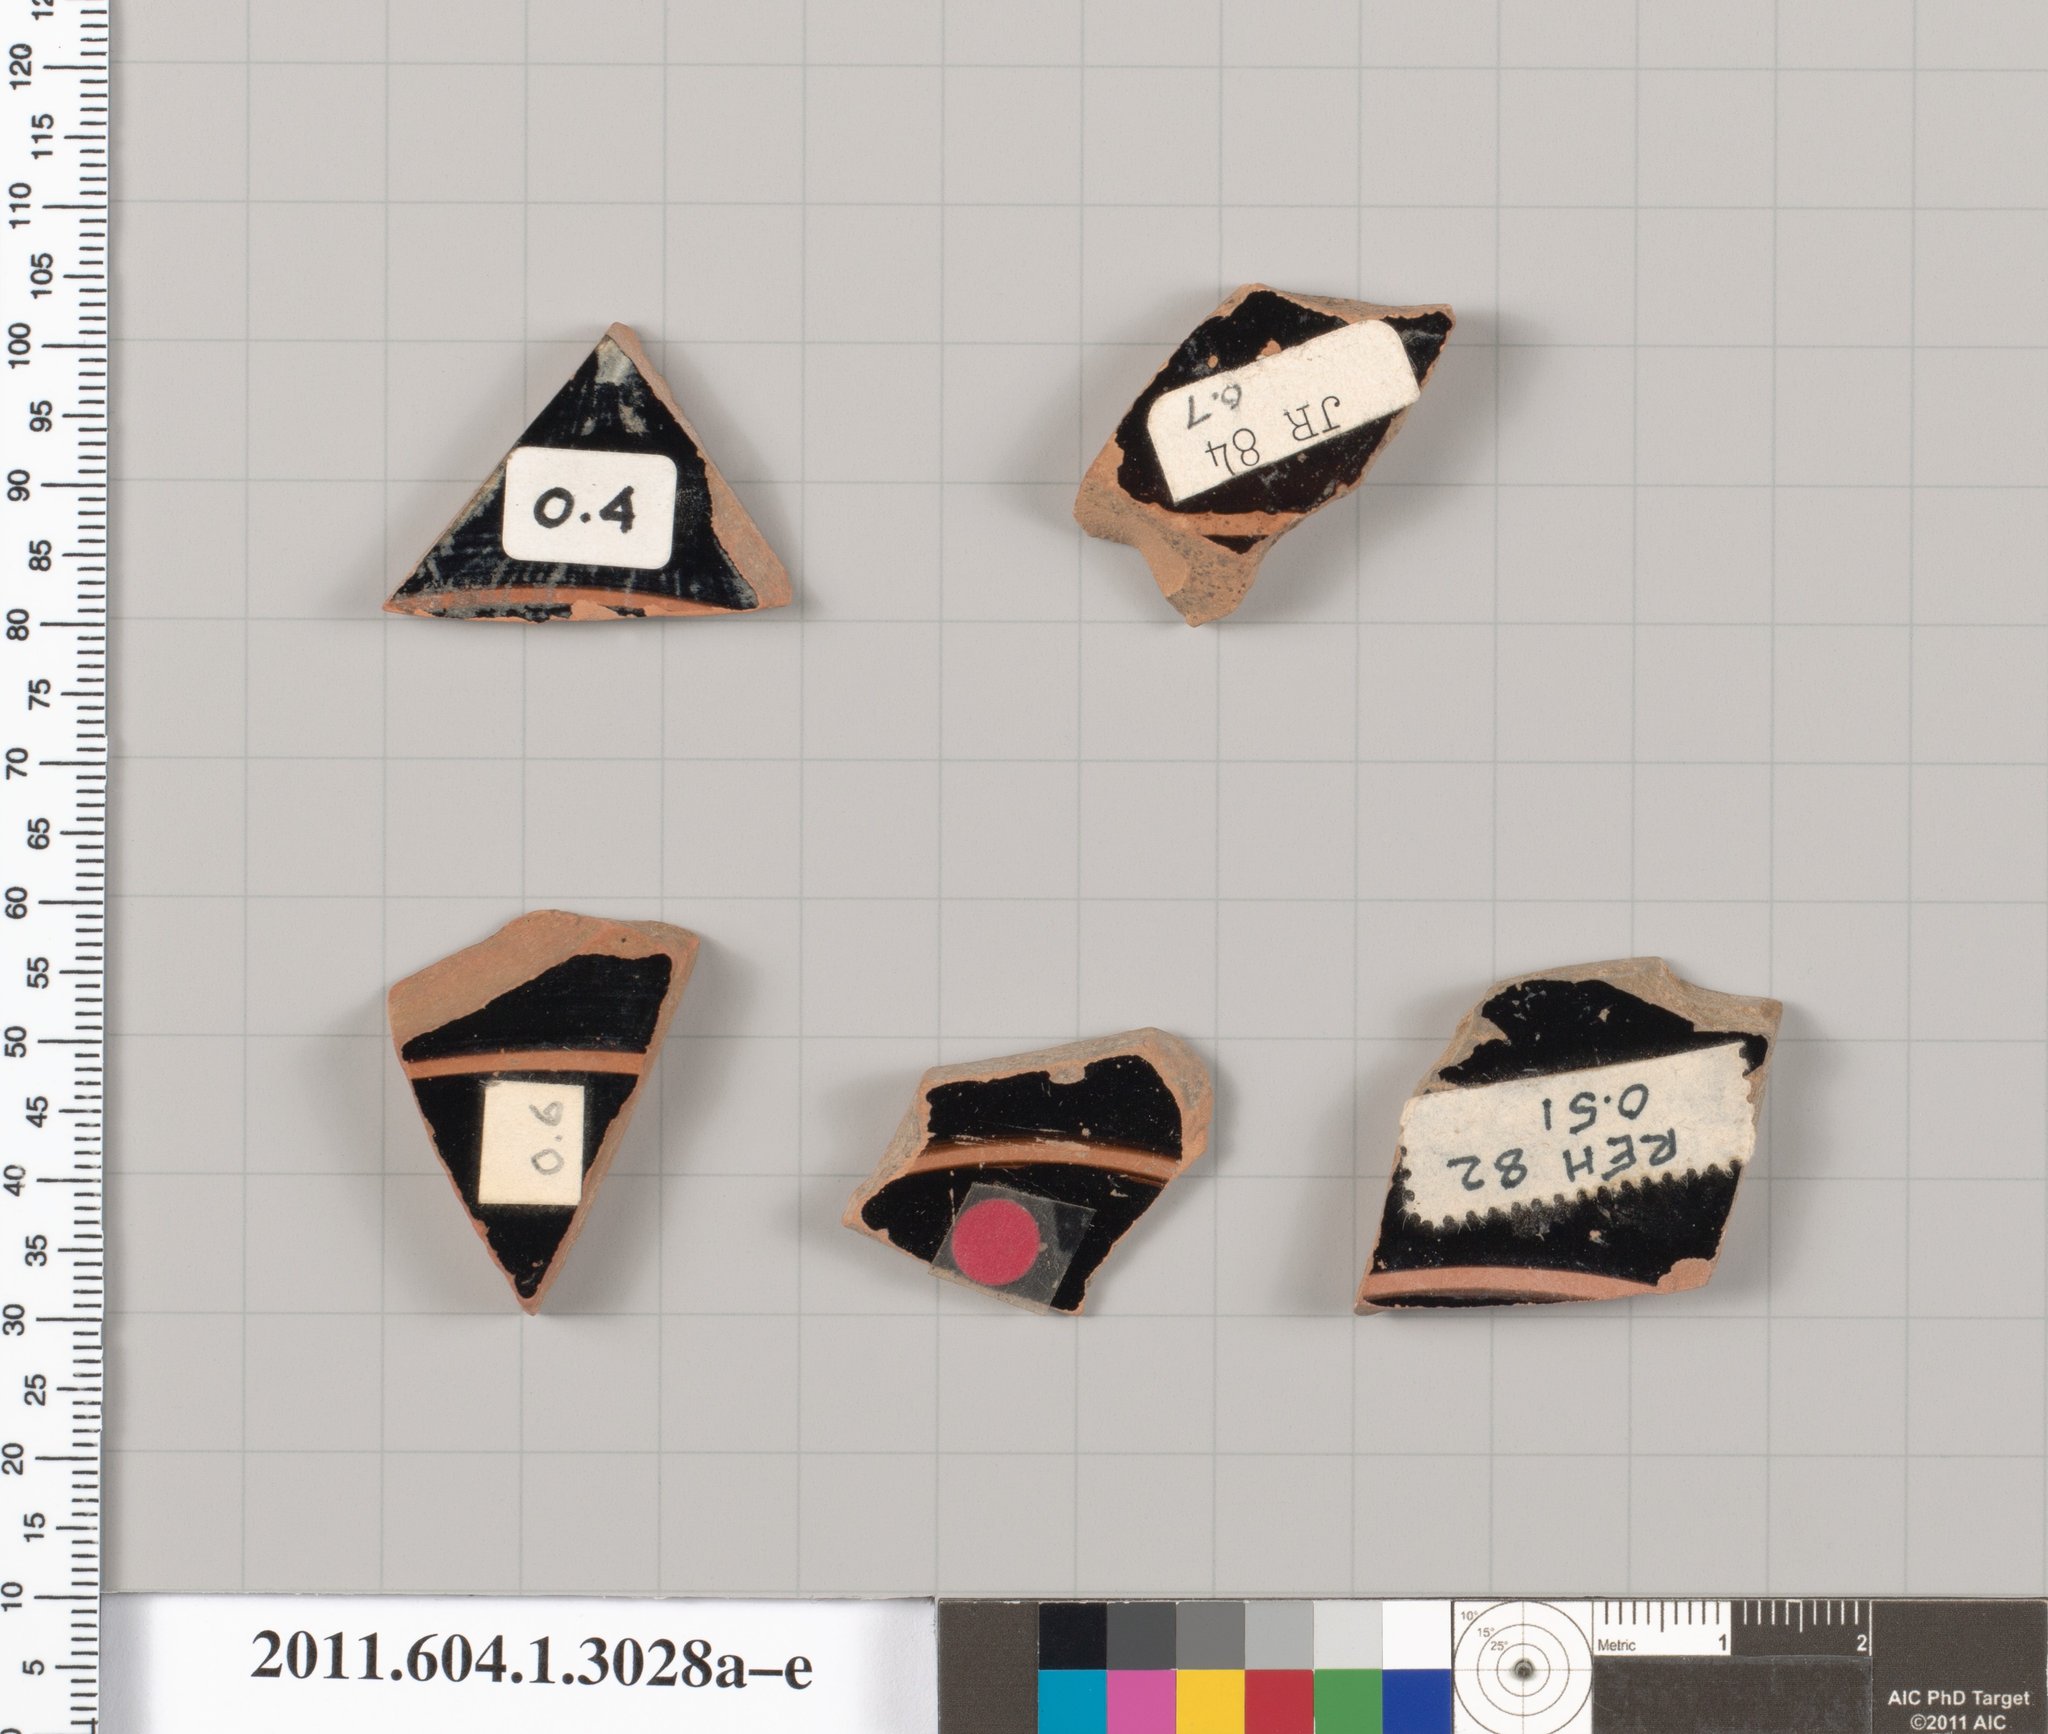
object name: kylix fragment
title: Terracotta fragments of kylikes (drinking cups)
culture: greek, attic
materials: terracotta